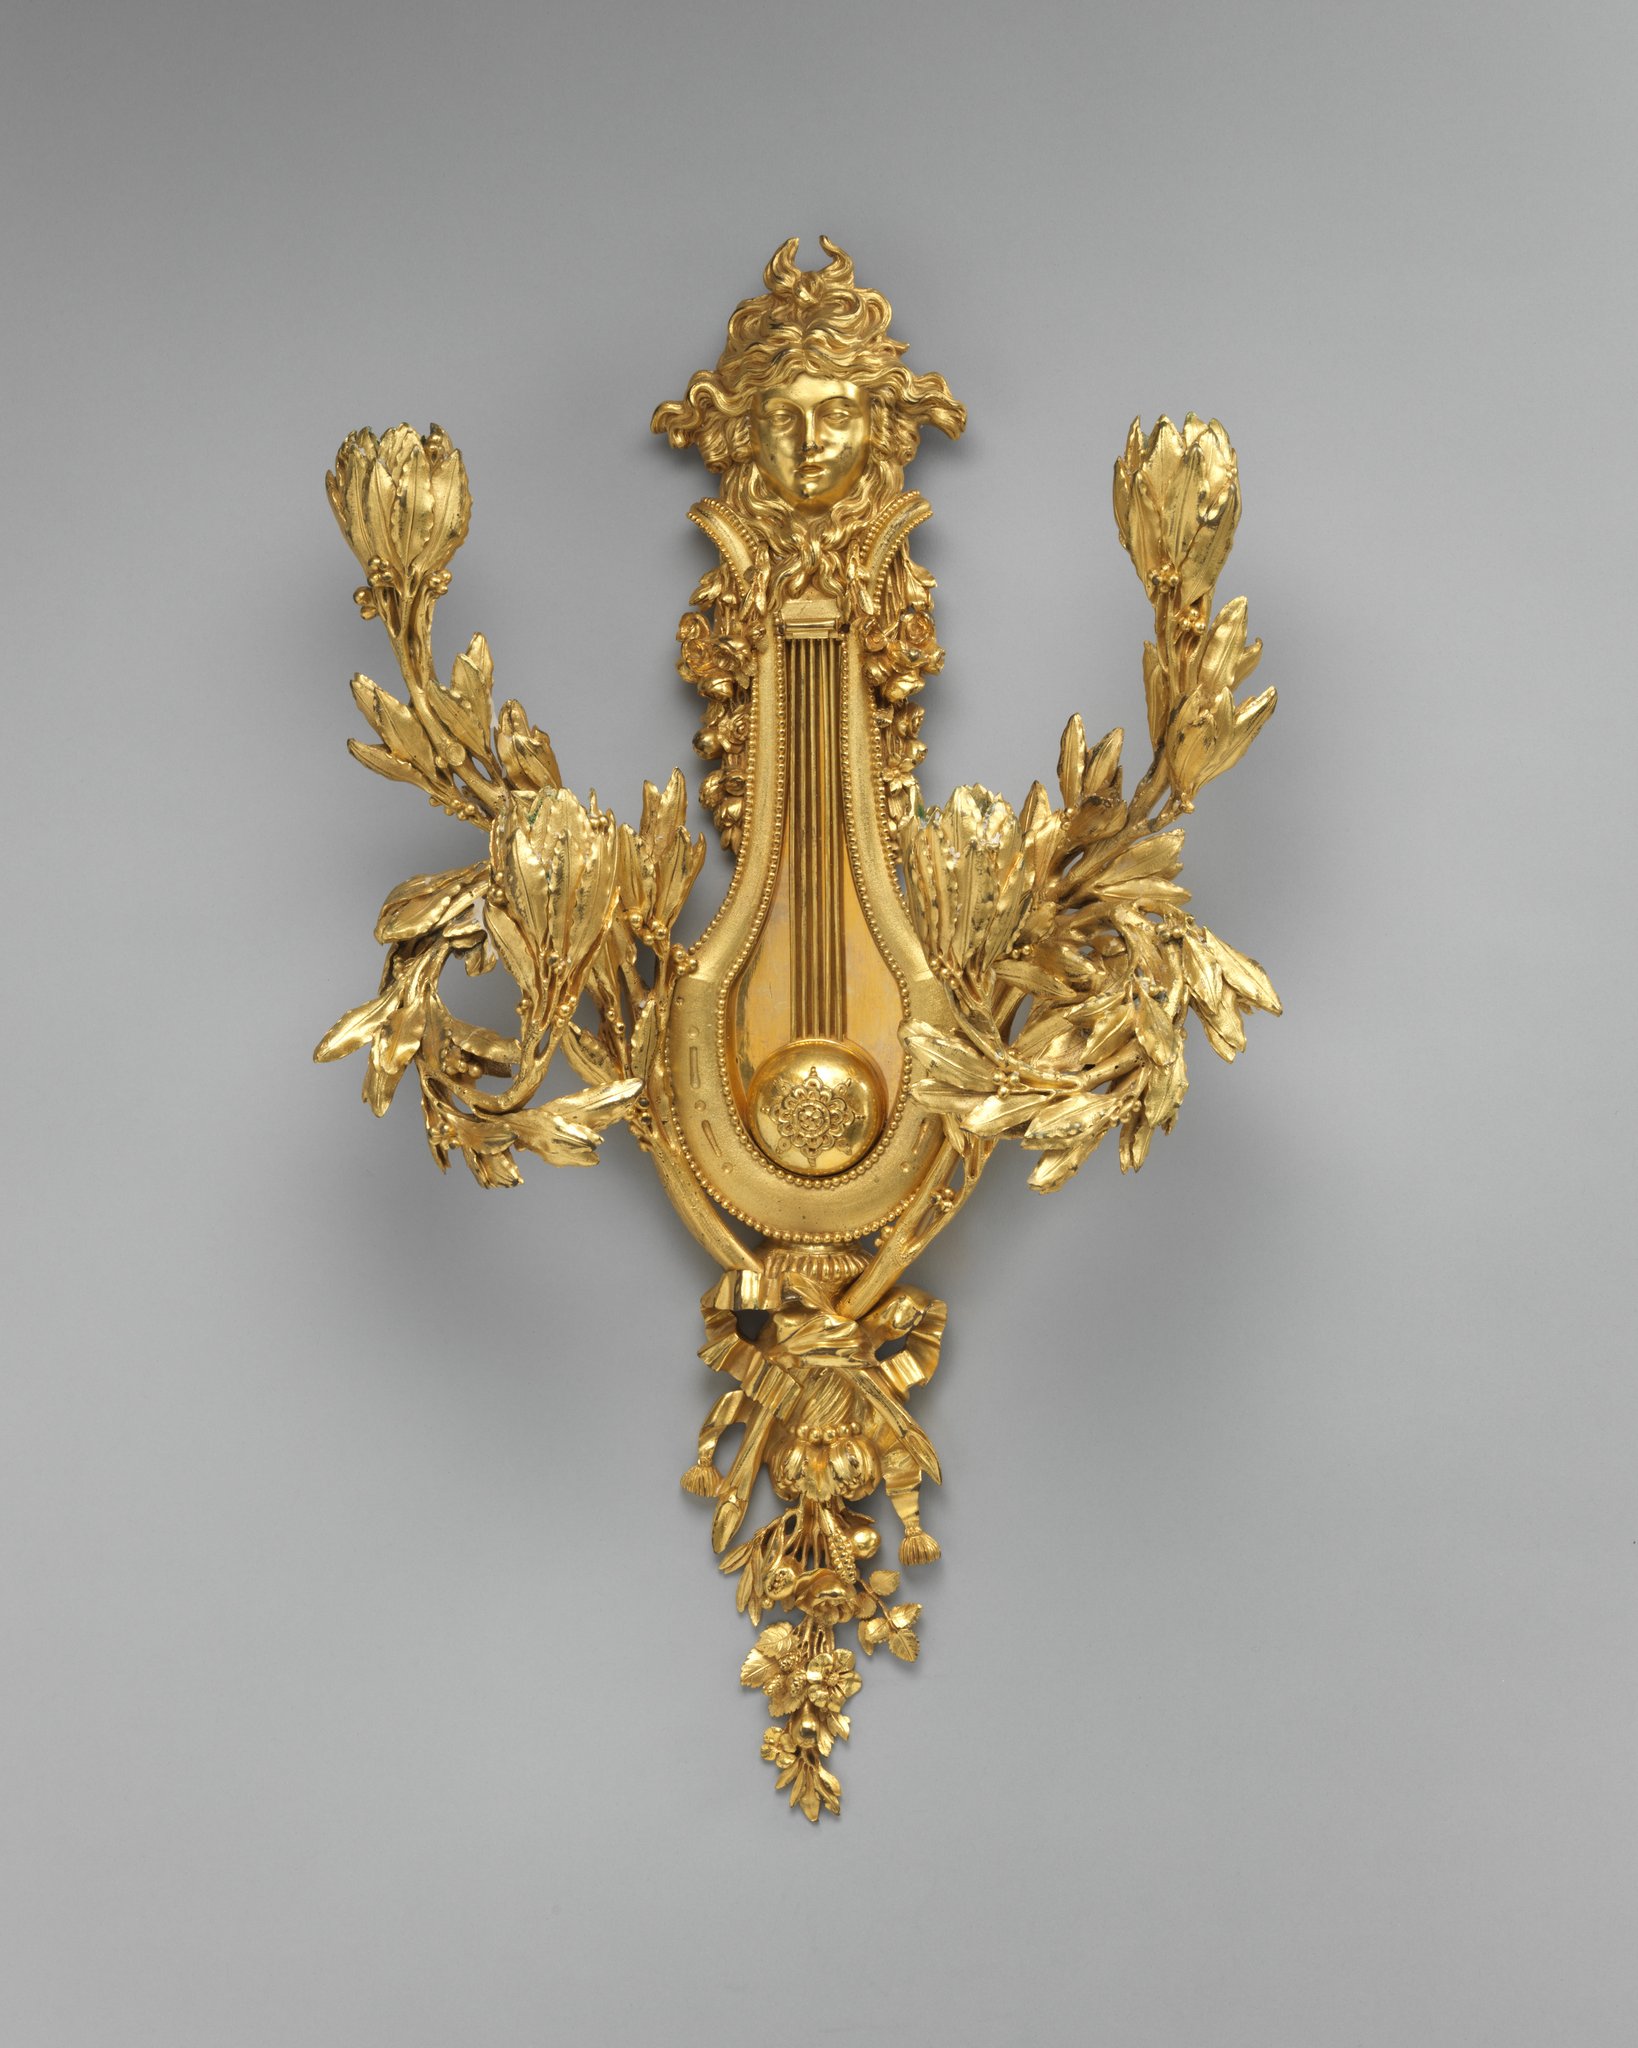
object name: wall light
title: Four-branched wall light in form of lyre (one of a set of four)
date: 1780-1789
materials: gilt bronze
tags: lyres